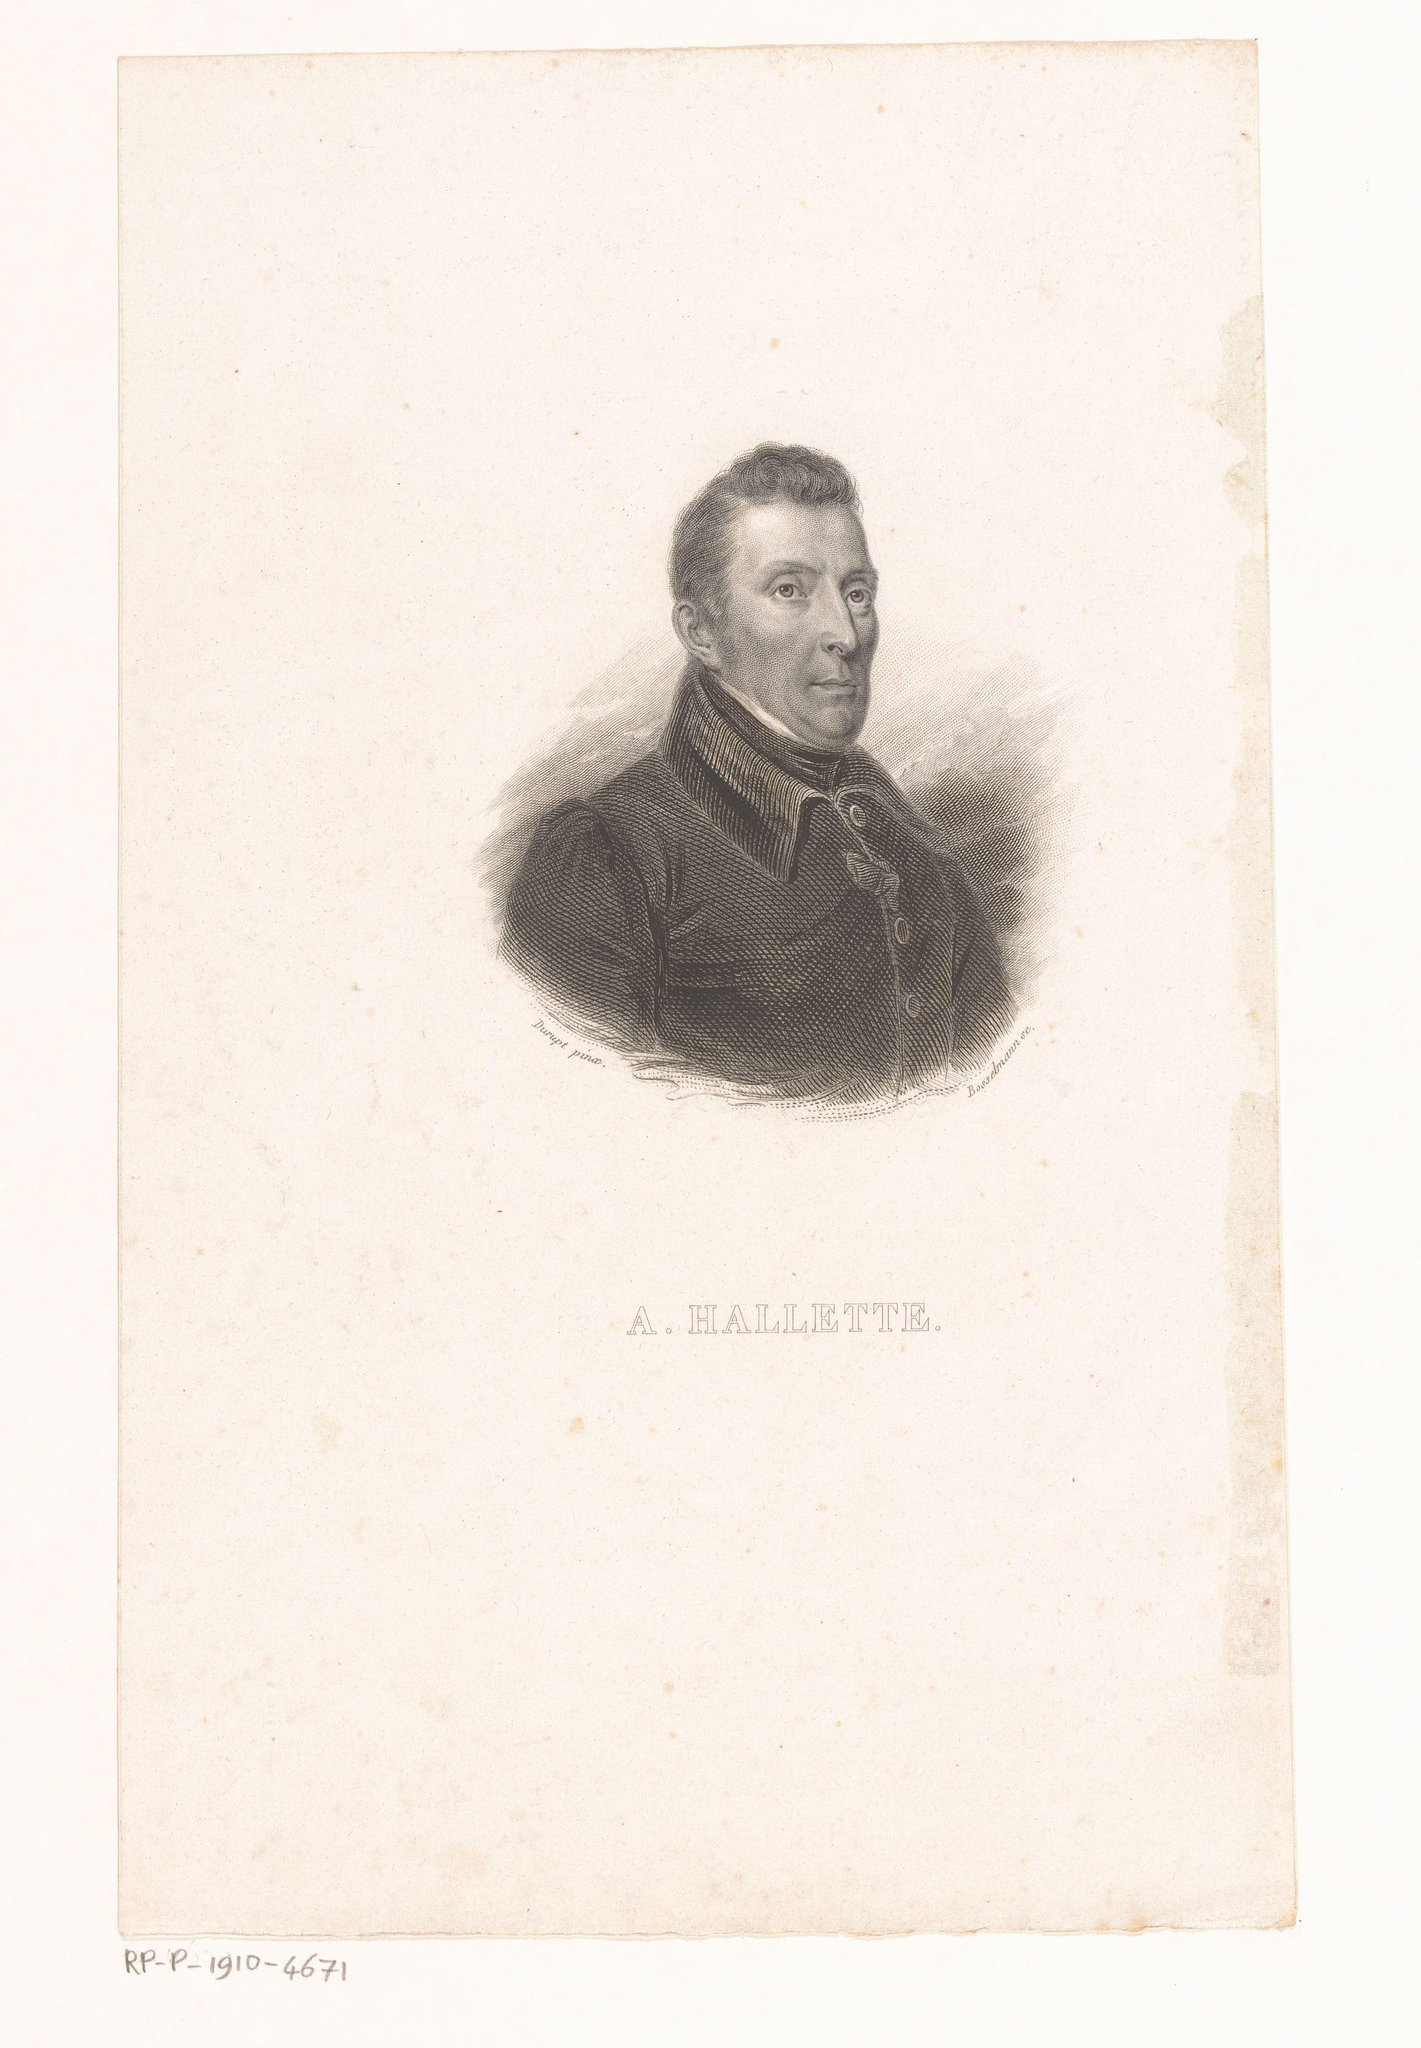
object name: print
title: A. Hallette.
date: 1825-1841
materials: paper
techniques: engraving, etching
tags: historical persons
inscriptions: collector's mark: Lugt 2228